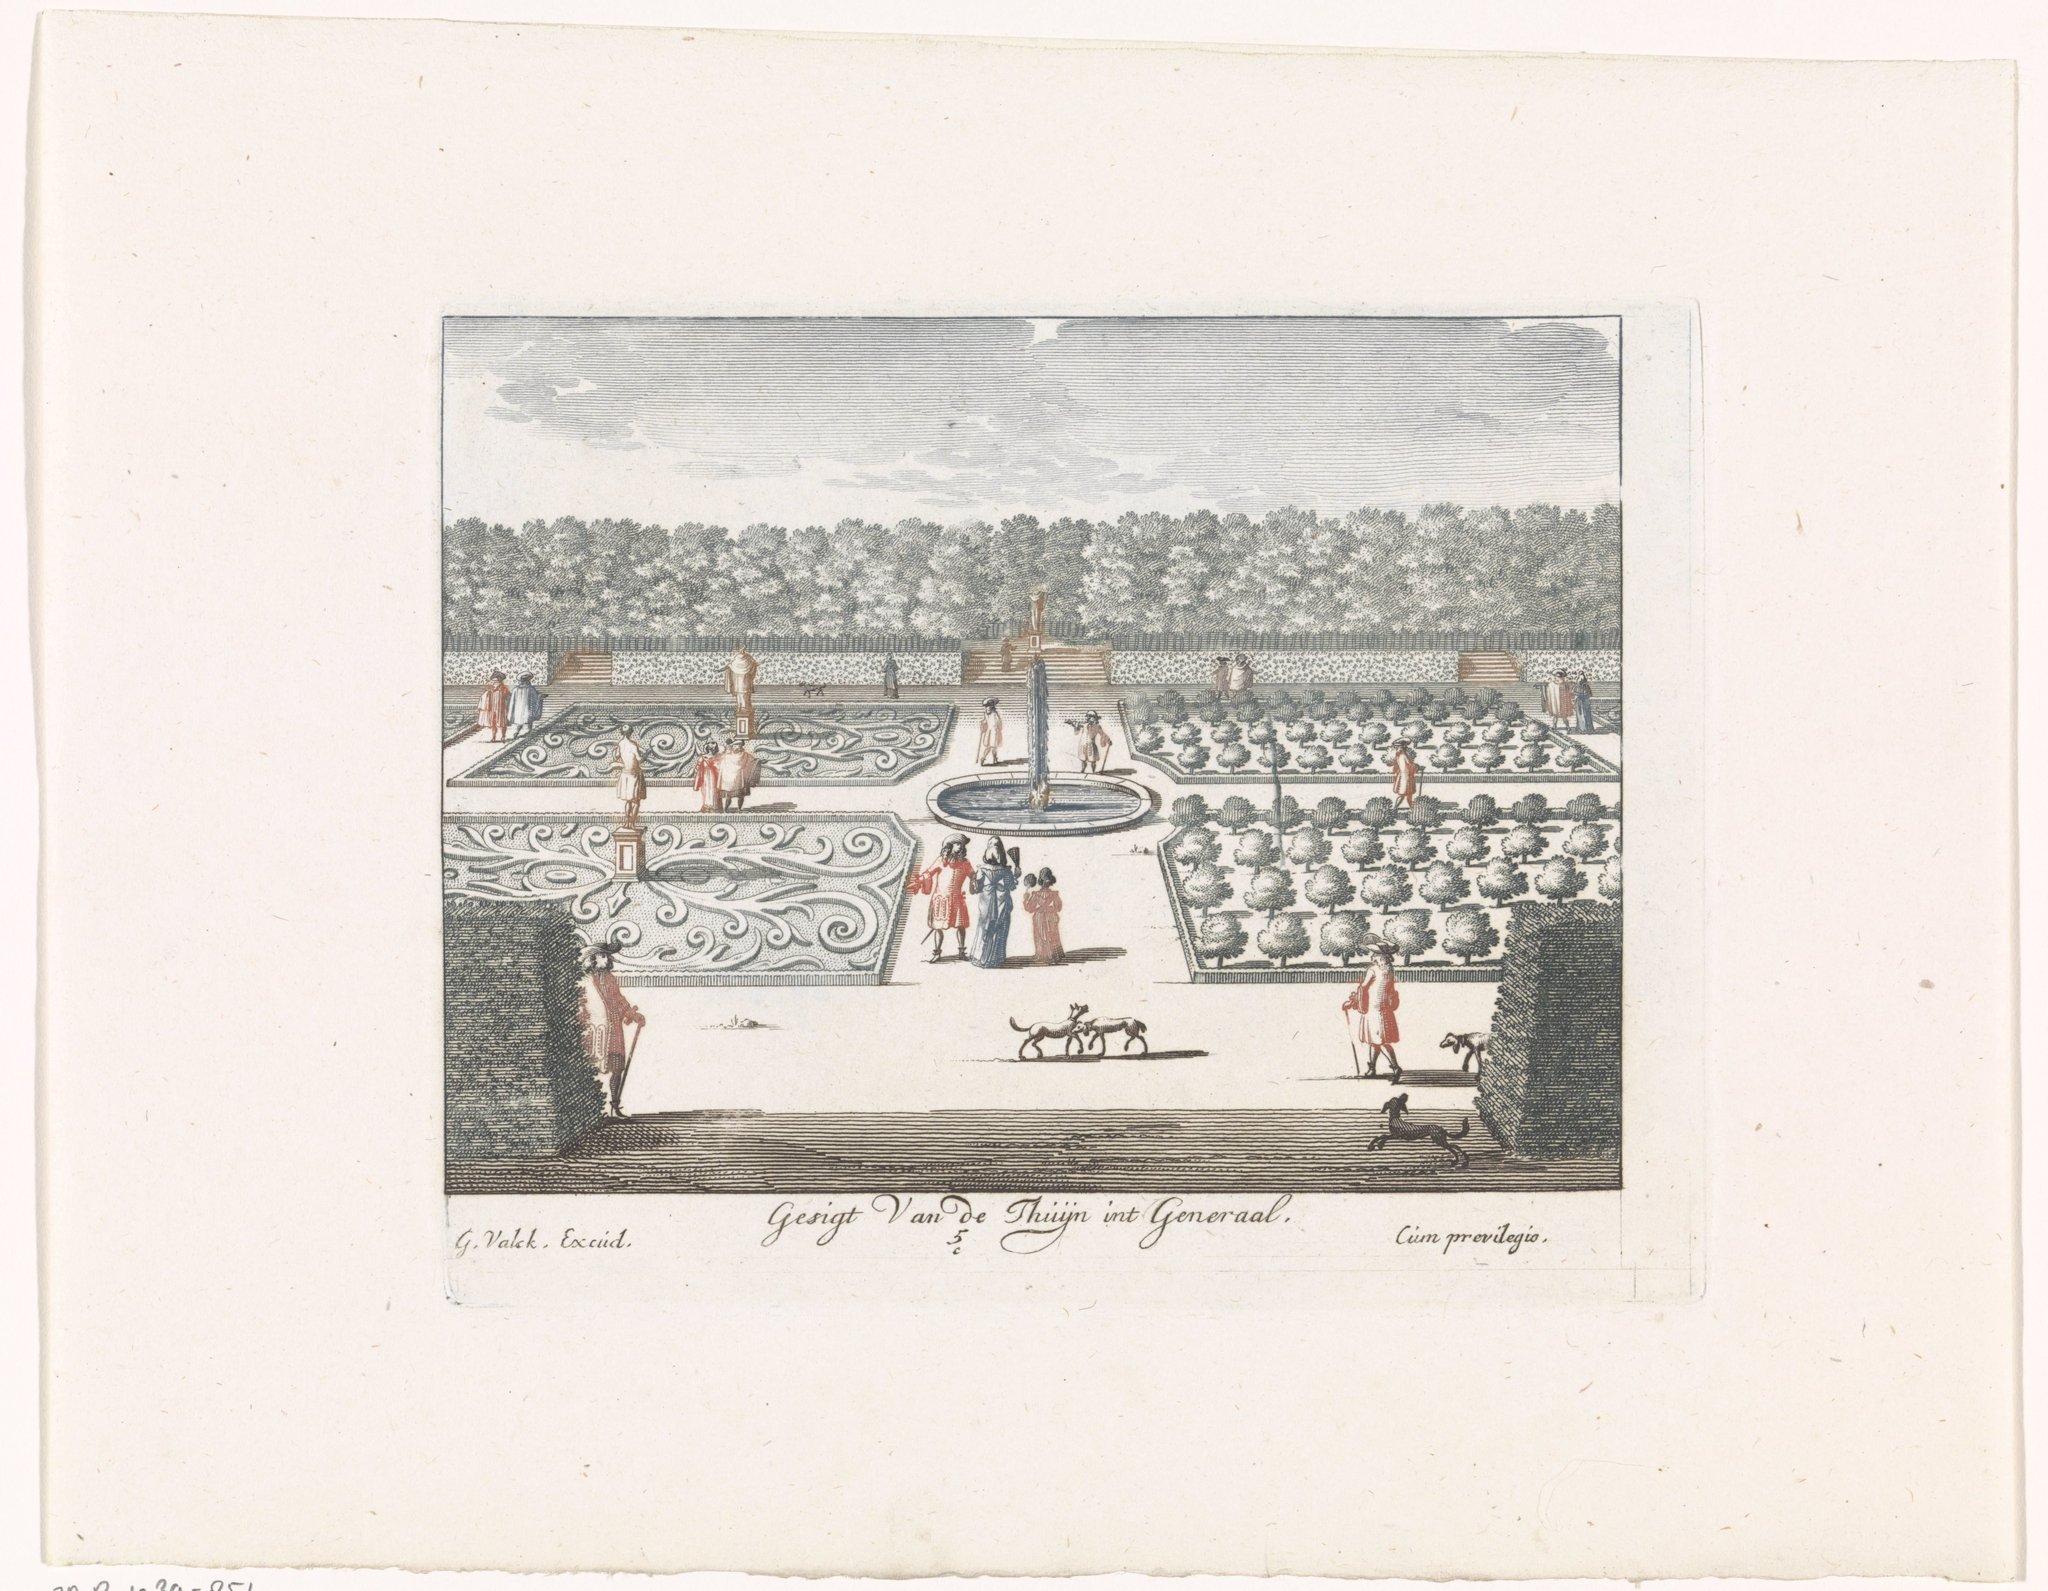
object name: print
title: Veues et perspectives de Soesdyck, chasteau & maison de plaisance du roy de la Grande Bretagne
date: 1695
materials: paper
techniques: etching, lithography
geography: amsterdam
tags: the hague, william iii (prince of orange and king of england, scotland, and ireland), garden fountain, french or architectonic garden; formal garden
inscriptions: collector's mark: Lugt 2760, collector's mark: Lugt 2228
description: Achterzijde van Paleis Soestdijk, jachtslot van stadhouder Willem III van Oranje-Nassau. Op de voorgrond figuren in de tuin.